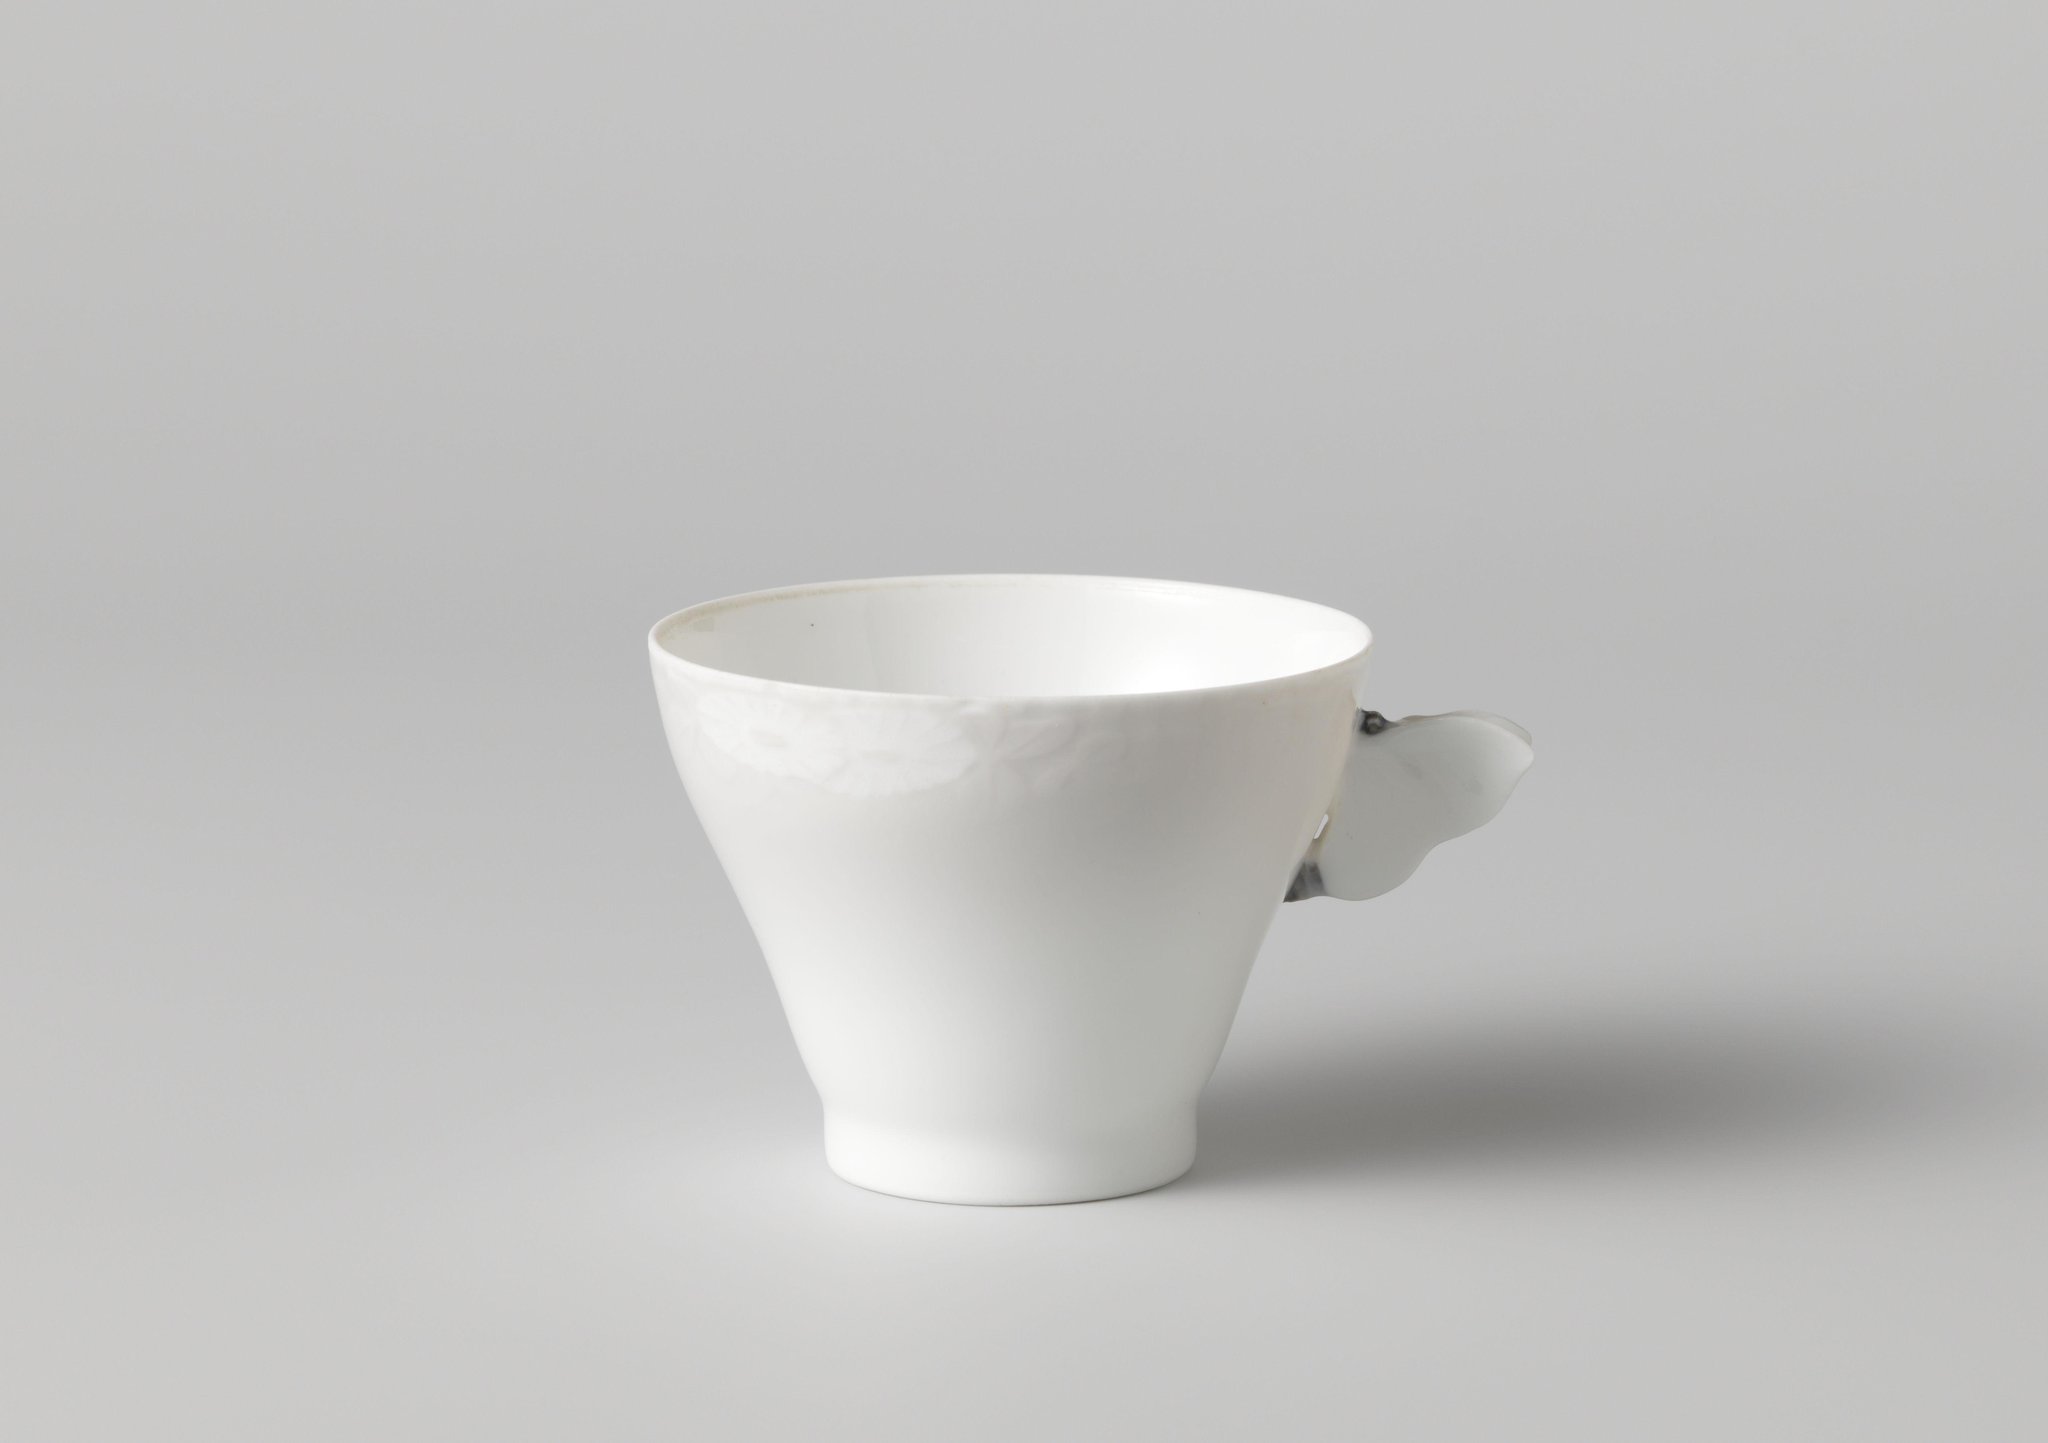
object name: cup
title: Kop, behorende bij een servies met libellen, vlinders en andere insekten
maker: arnold emil krog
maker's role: ceramicist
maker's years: 1856-1937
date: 1894-1899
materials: porcelain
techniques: painted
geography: copenhagen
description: Parts of a tea and coffee service. Porcelain. Copenhagen, Den Kongelig Porcelainfabrik, c. 1894 - 1899, designed by Arnold Krog.